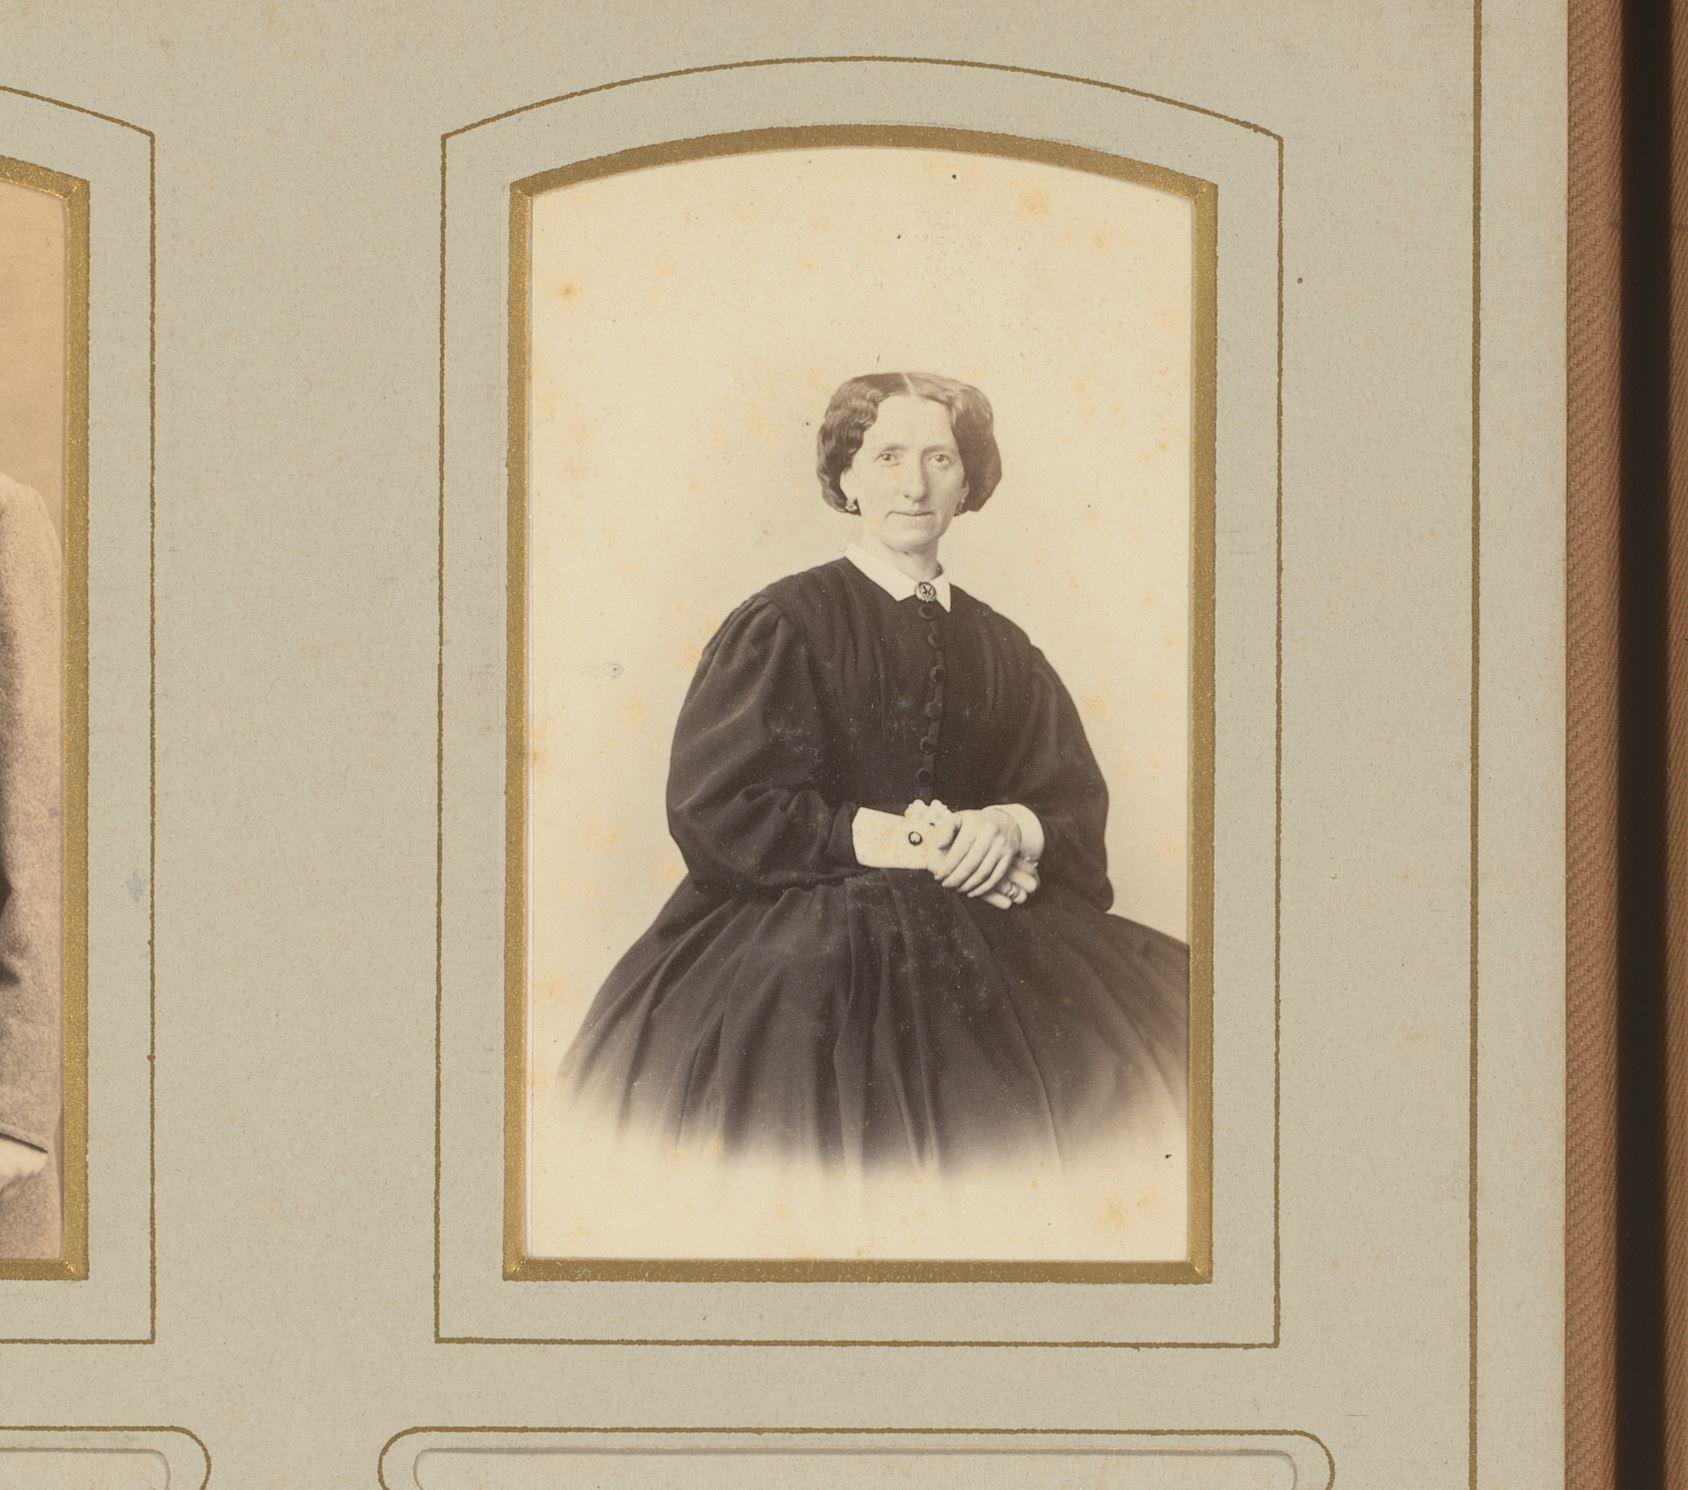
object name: photograph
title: Portret van een zittende vrouw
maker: césar mitkiewicz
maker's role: fotograaf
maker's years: 1836-1871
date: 1860-1900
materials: cardboard, photographic support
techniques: albumen print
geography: brussels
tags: sitting figure - aa - female human figure, historical persons - bb - woman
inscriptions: inscription: ‘CESAR MITKIEWICZ/ PHOTOGRAPHE/ 9, Rue Neuve, 9/ BRUXELLES’